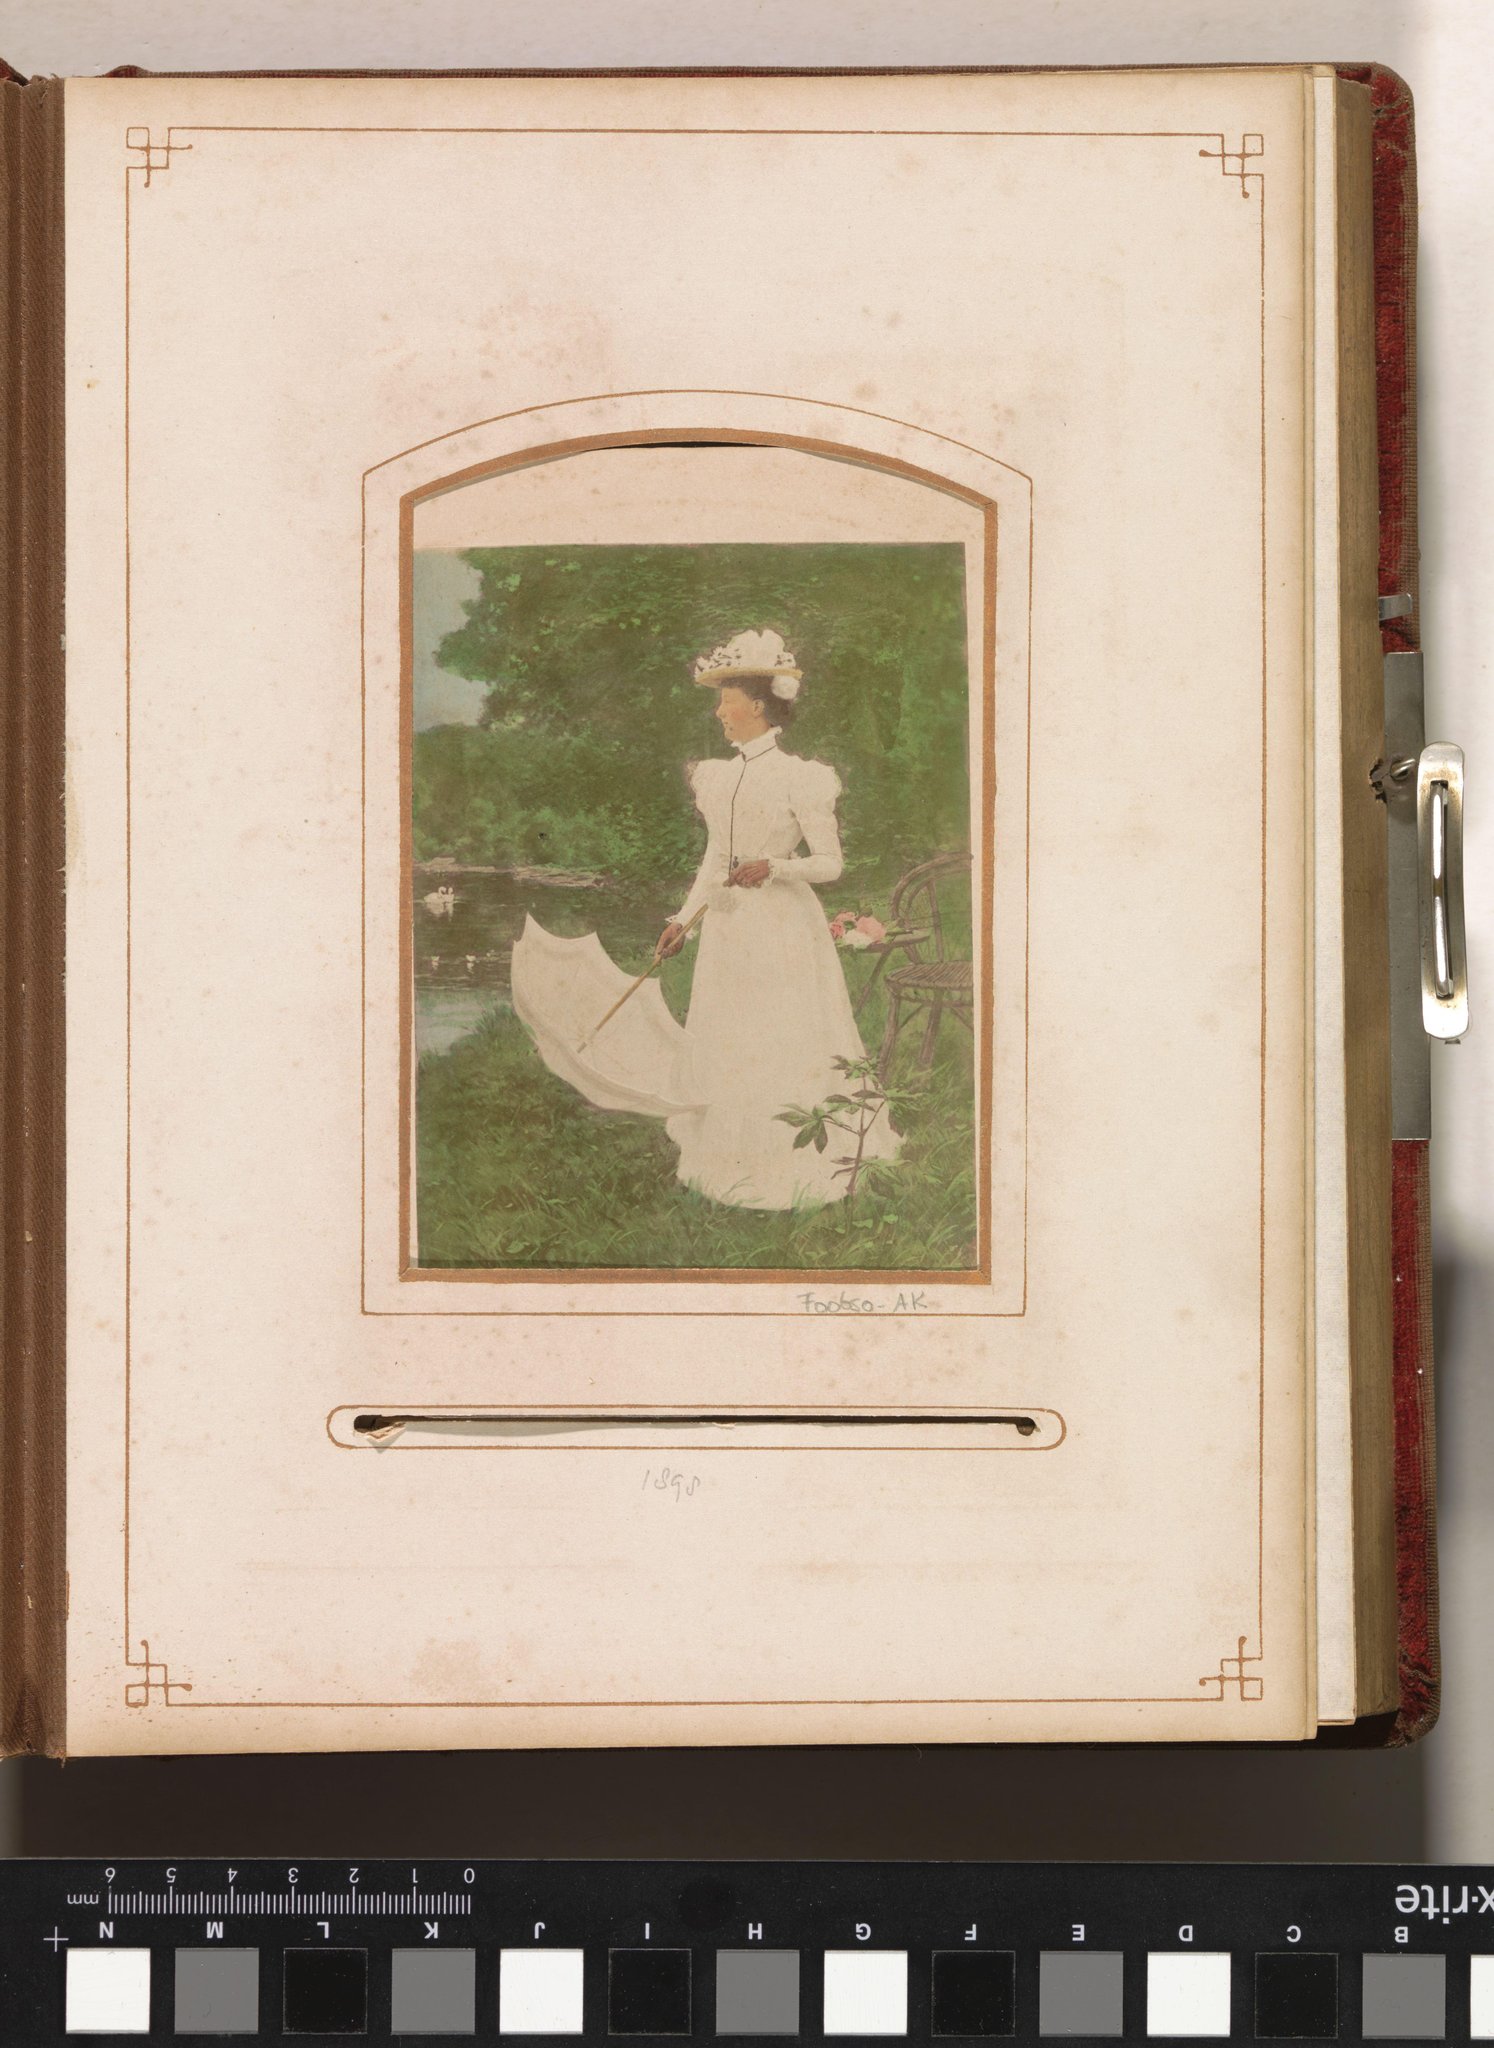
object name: album leaf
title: Portret van koningin Wilhelmina met parasol in een tuin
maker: Anonymous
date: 1898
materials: cardboard, paper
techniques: albumen print, hand coloring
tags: the hague, print maker, wilhelmina of the netherlands, historical persons - bb - woman, queen, parasol, sunshade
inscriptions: date: ‘16/7-1898’